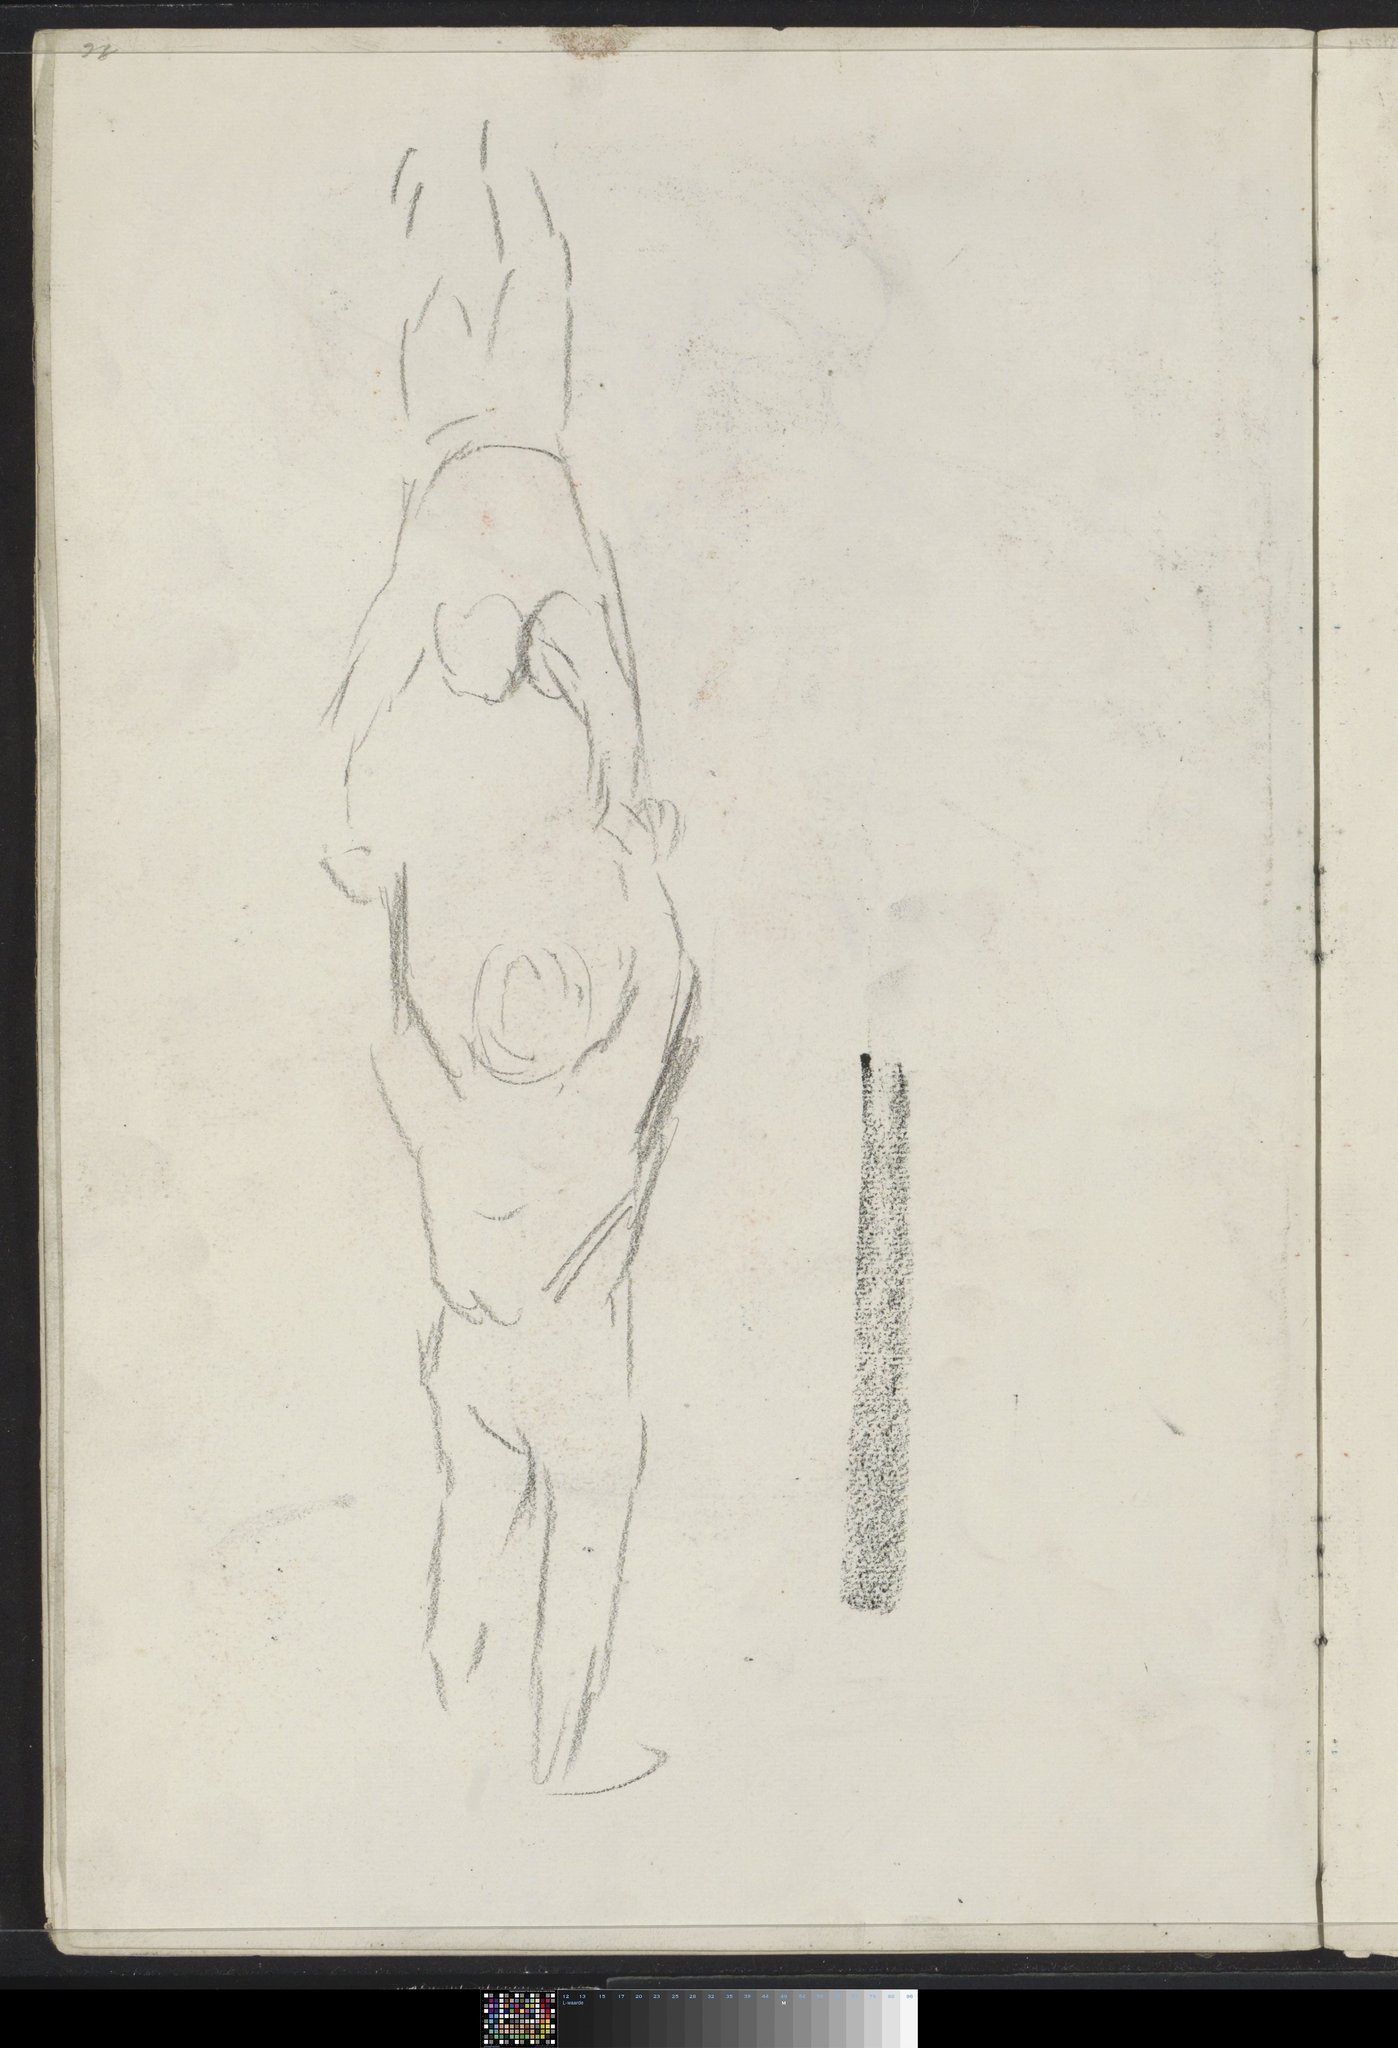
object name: sketchbook leaf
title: Twee acrobaten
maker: isaac israels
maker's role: draughtsman, painter, print maker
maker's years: 1865-1934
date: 1875-1934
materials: chalk, paper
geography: the hague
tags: acrobat ~ circus, standing on the head or on the hands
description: Man in handstand op de handen van een andere man. Blad 7 verso uit schetsboek LXVIII met 11 bladen.